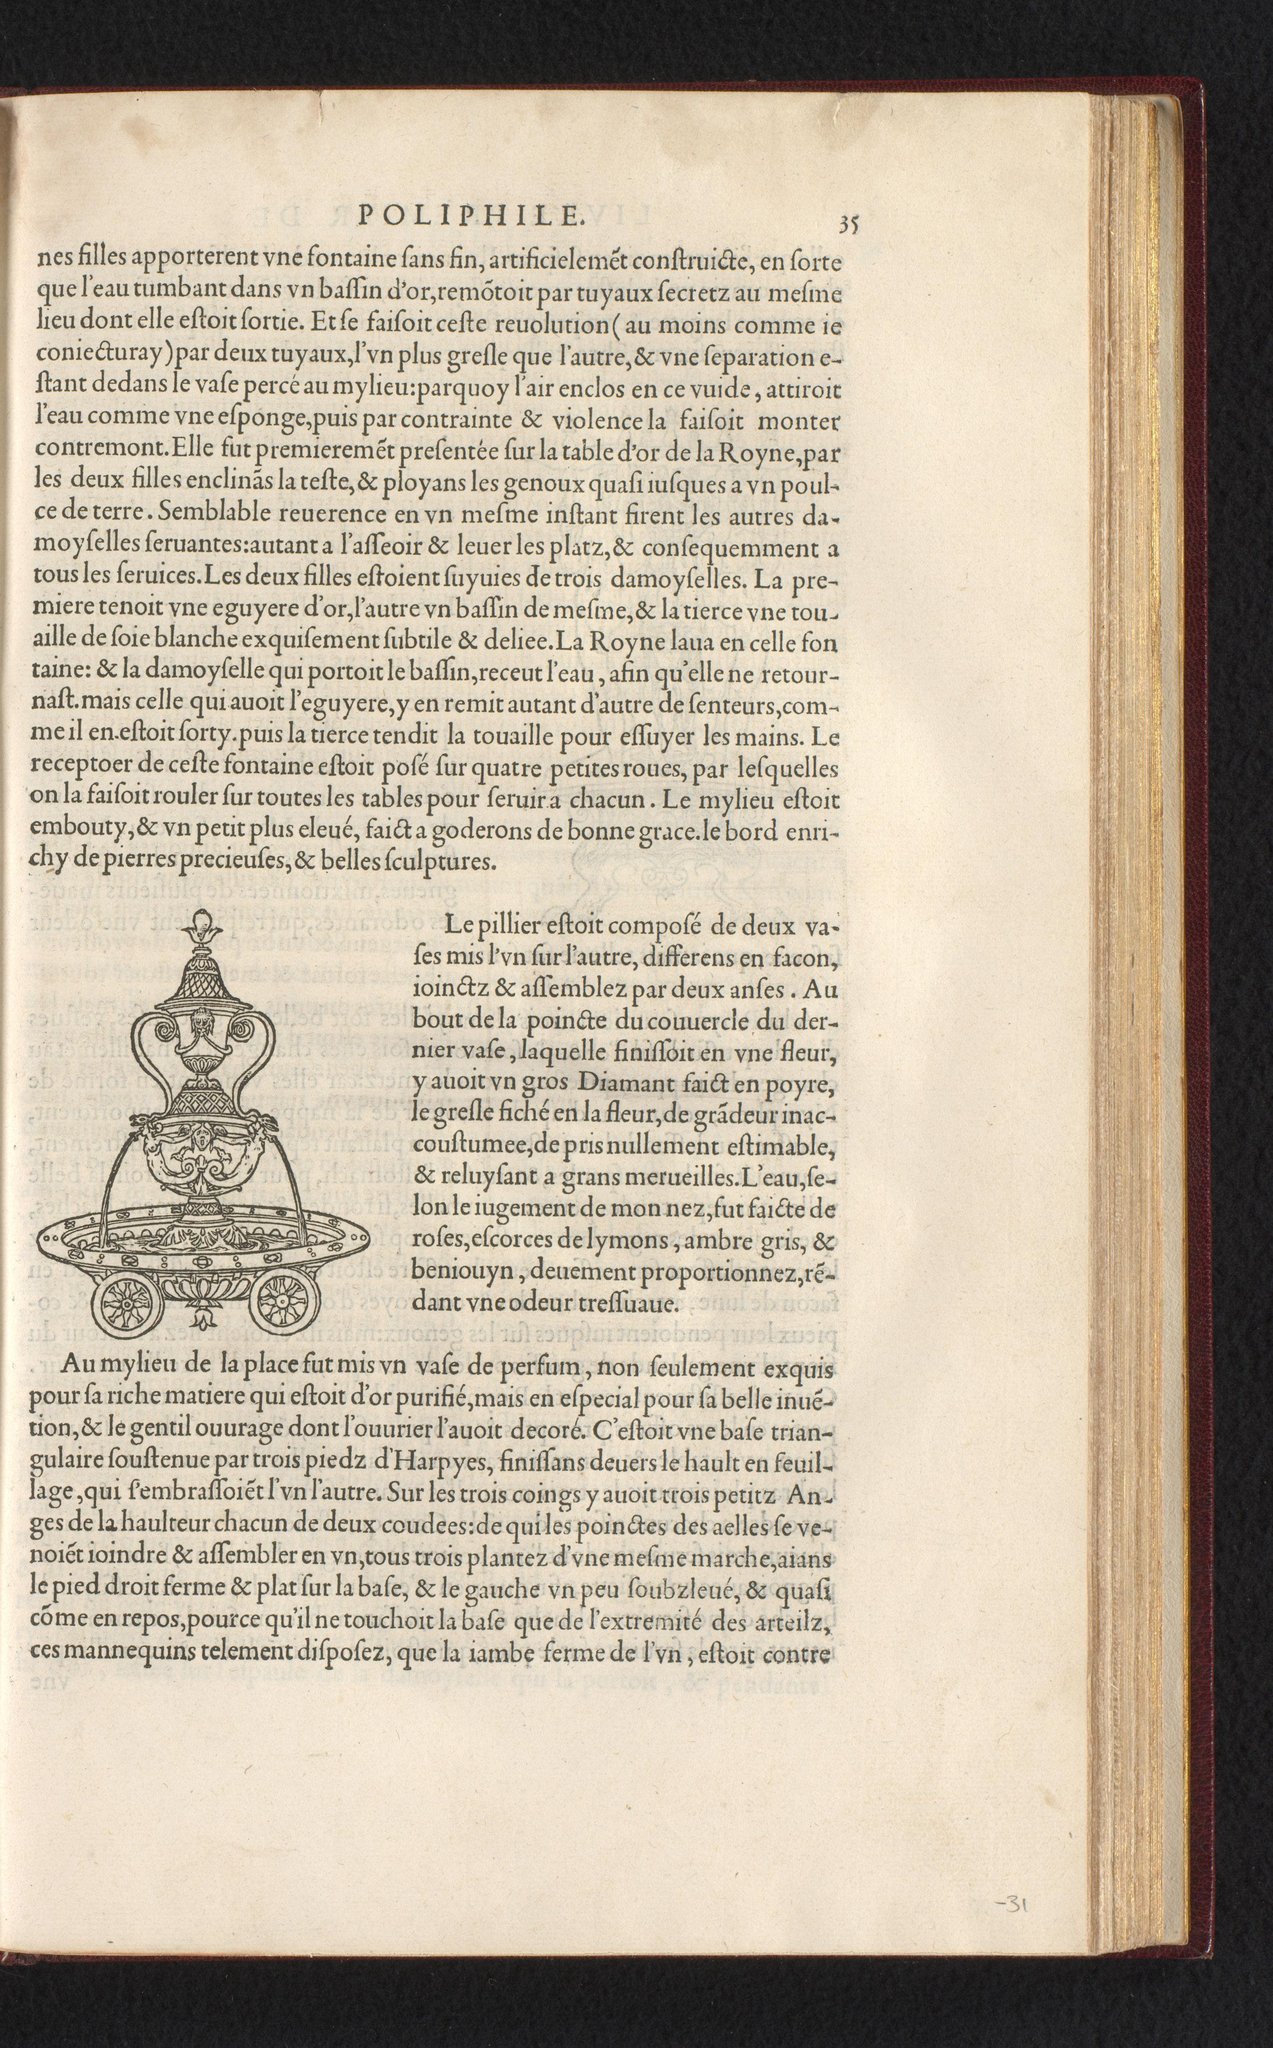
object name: print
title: Fontein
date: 1546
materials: paper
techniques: letterpress printing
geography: paris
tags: (scenes from) specific works of literature: colonna, hypnerotomachia poliphili, ornamental fountain, fountain (indoors)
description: Prent uit: Colonna, Francesco. Hypnerotomachie ou discours du songe de Poliphile, deduisant comme amour le combat a l'occasion de Polia. Parijs: Jacques Kerver, 1546, recto fol. 35.